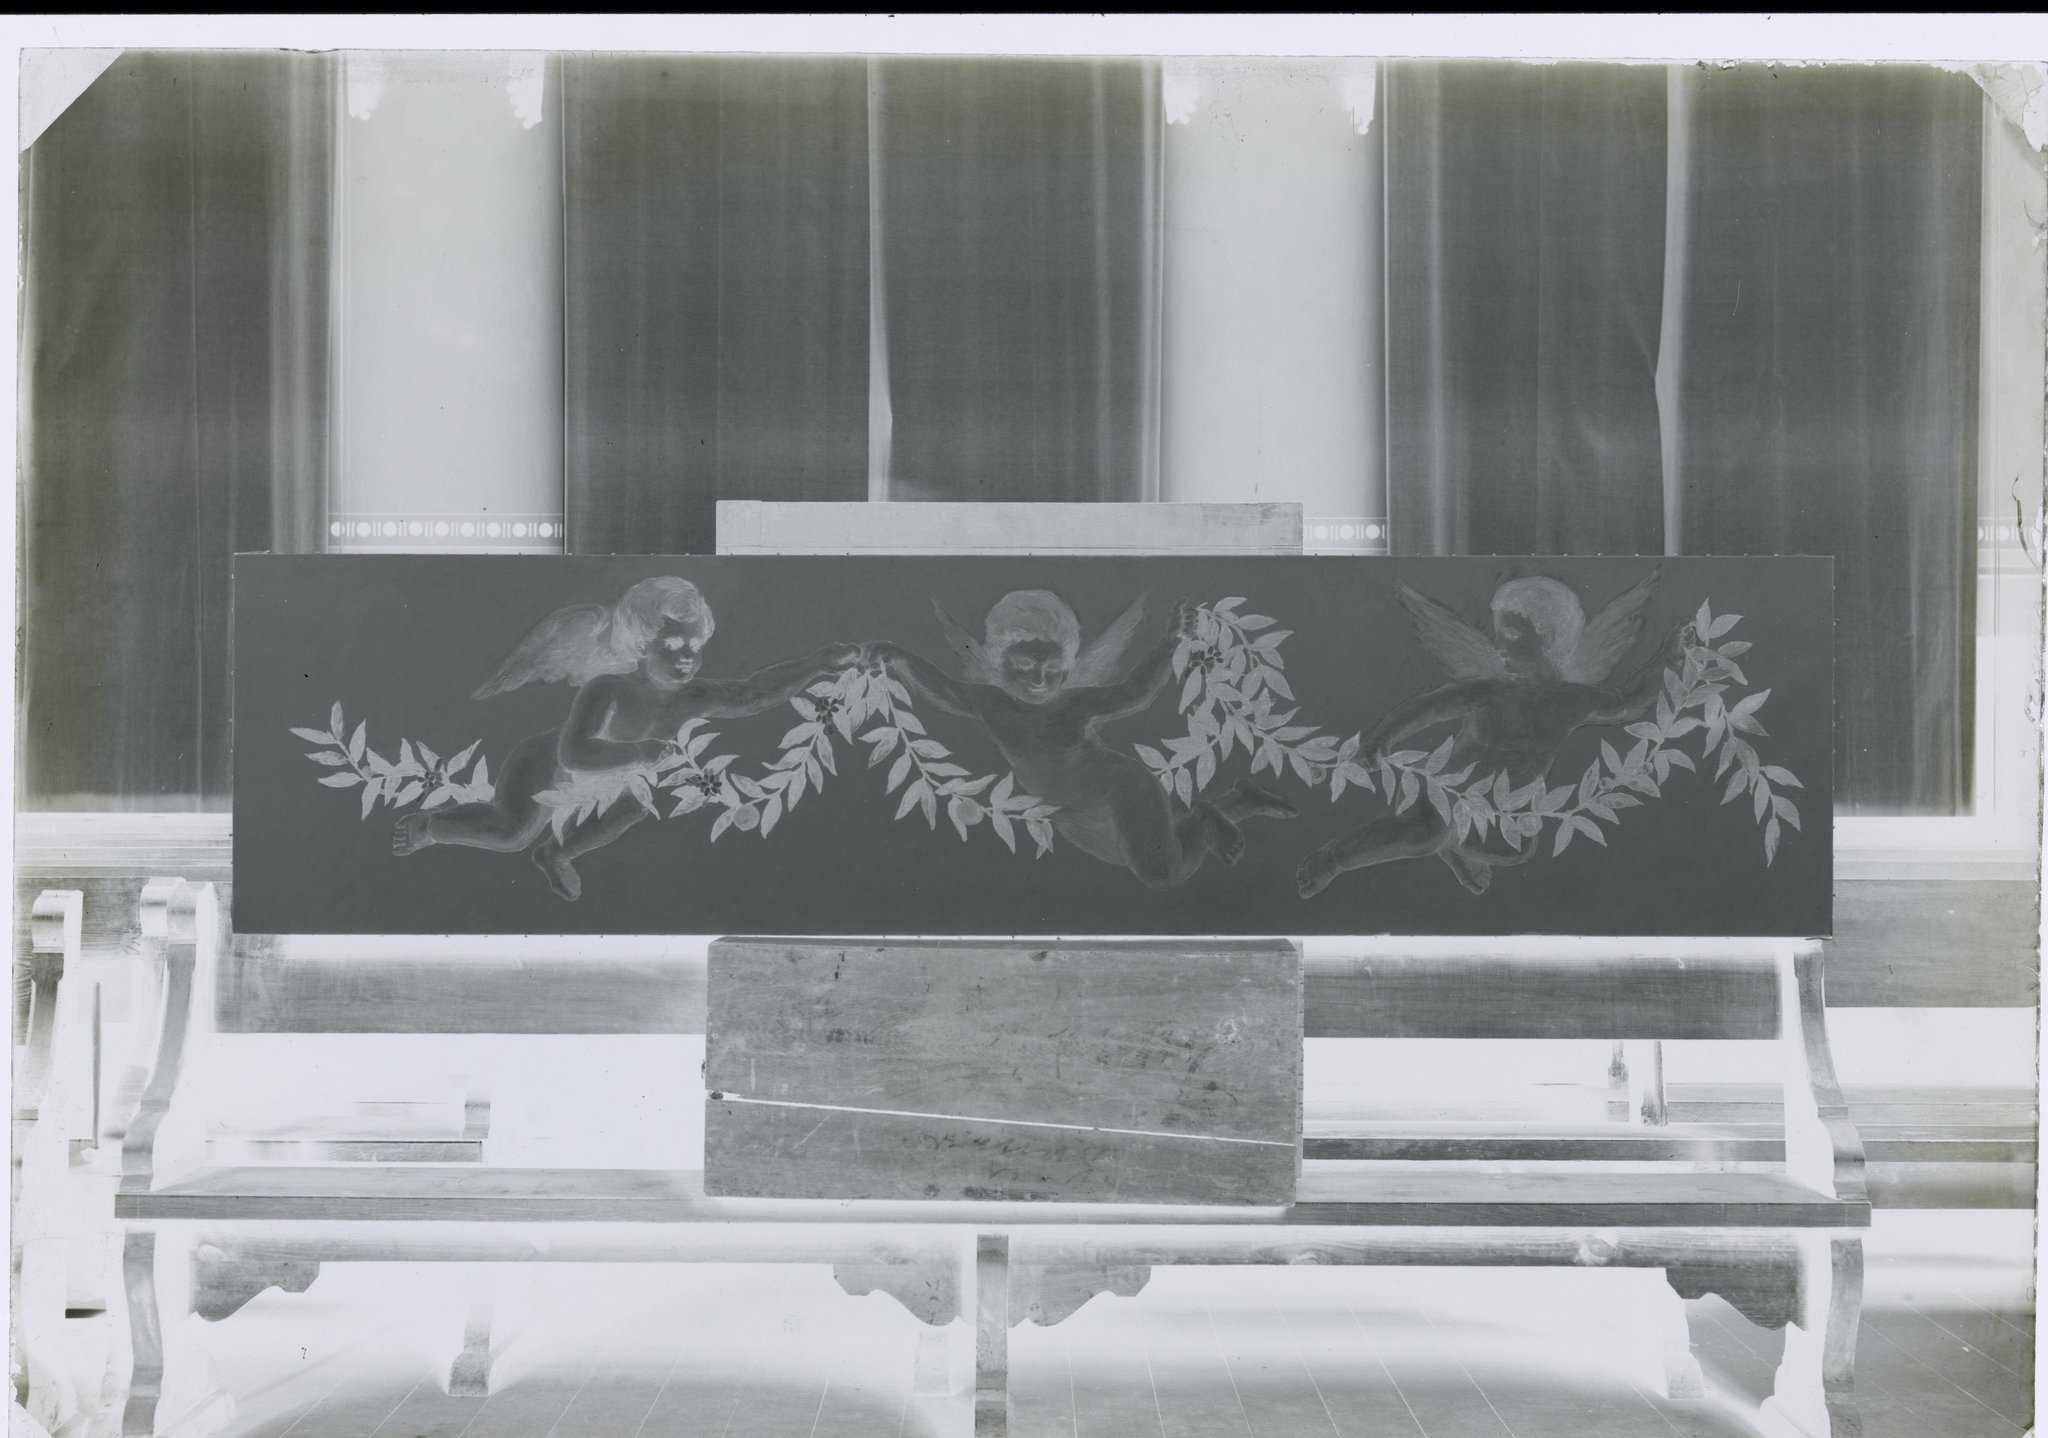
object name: reproduction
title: Fotoreproductie van een liggend schilderij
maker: laurens lodewijk kleijn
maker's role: draughtsman, painter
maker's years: 1826-1909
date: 1870-1900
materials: glass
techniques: collodion process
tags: picture, painting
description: Onderdeel van een groep glasnegatieven uit de nalatenschap van de schilder Laurens Lodewijk Kleijn, met stillevens, portretten, zelfportretten en kunstreproducties.